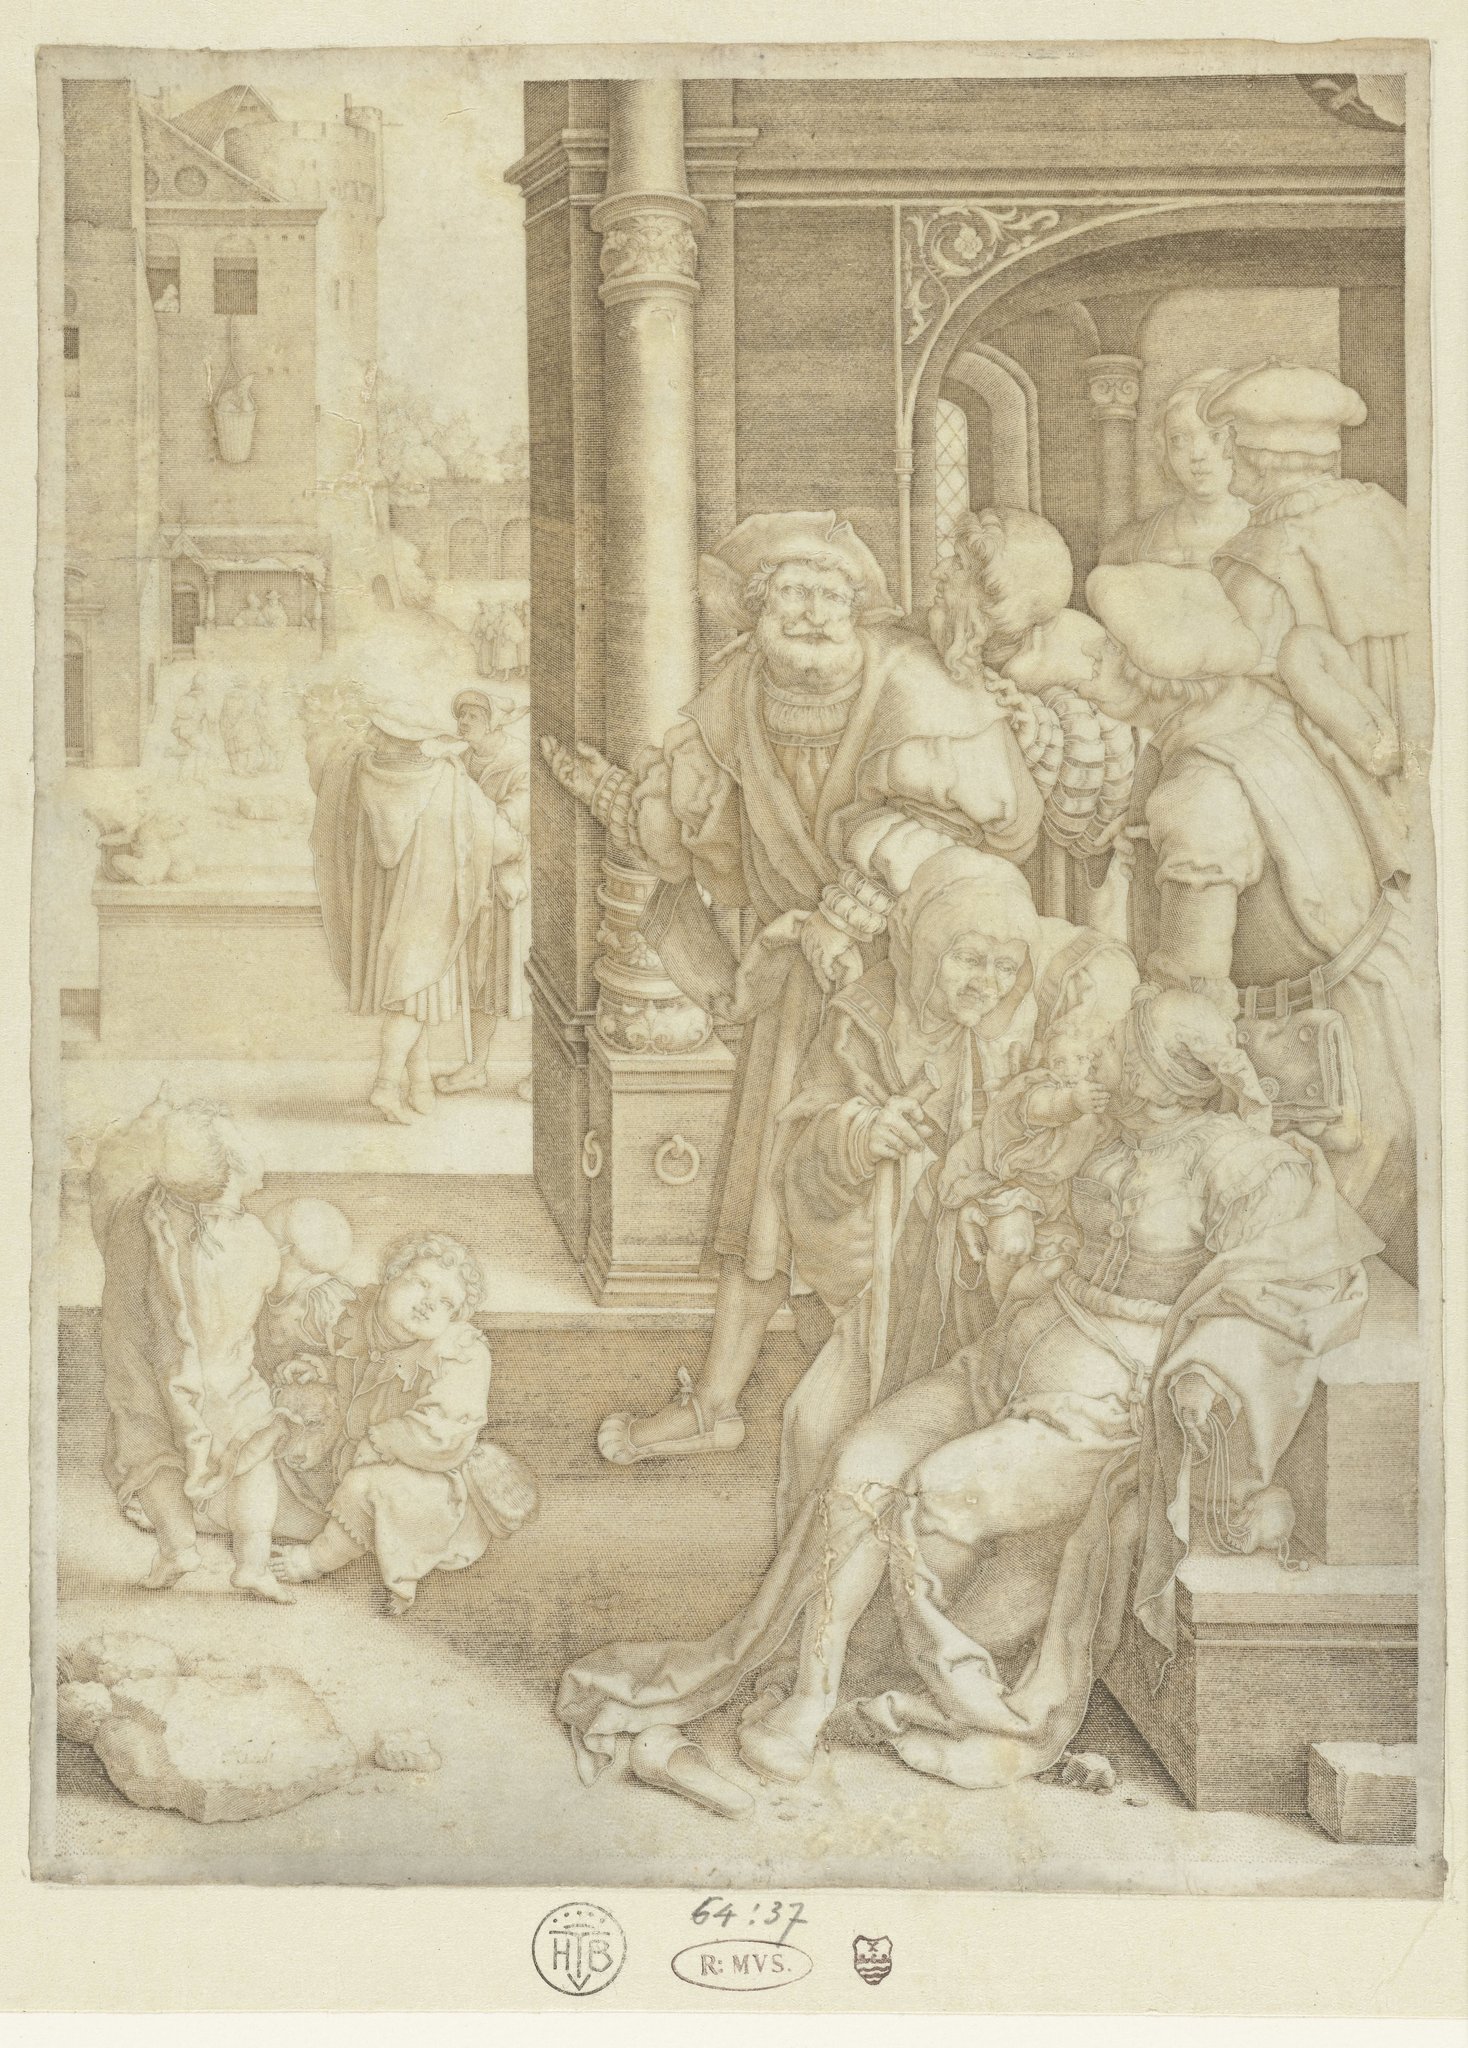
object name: drawing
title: Virgilius in de mand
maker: hendrick goudt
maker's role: draughtsman, print maker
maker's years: 1581-1648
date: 1596-1598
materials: ink, parchment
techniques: pen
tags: publius vergilius maro, virgil in the basket